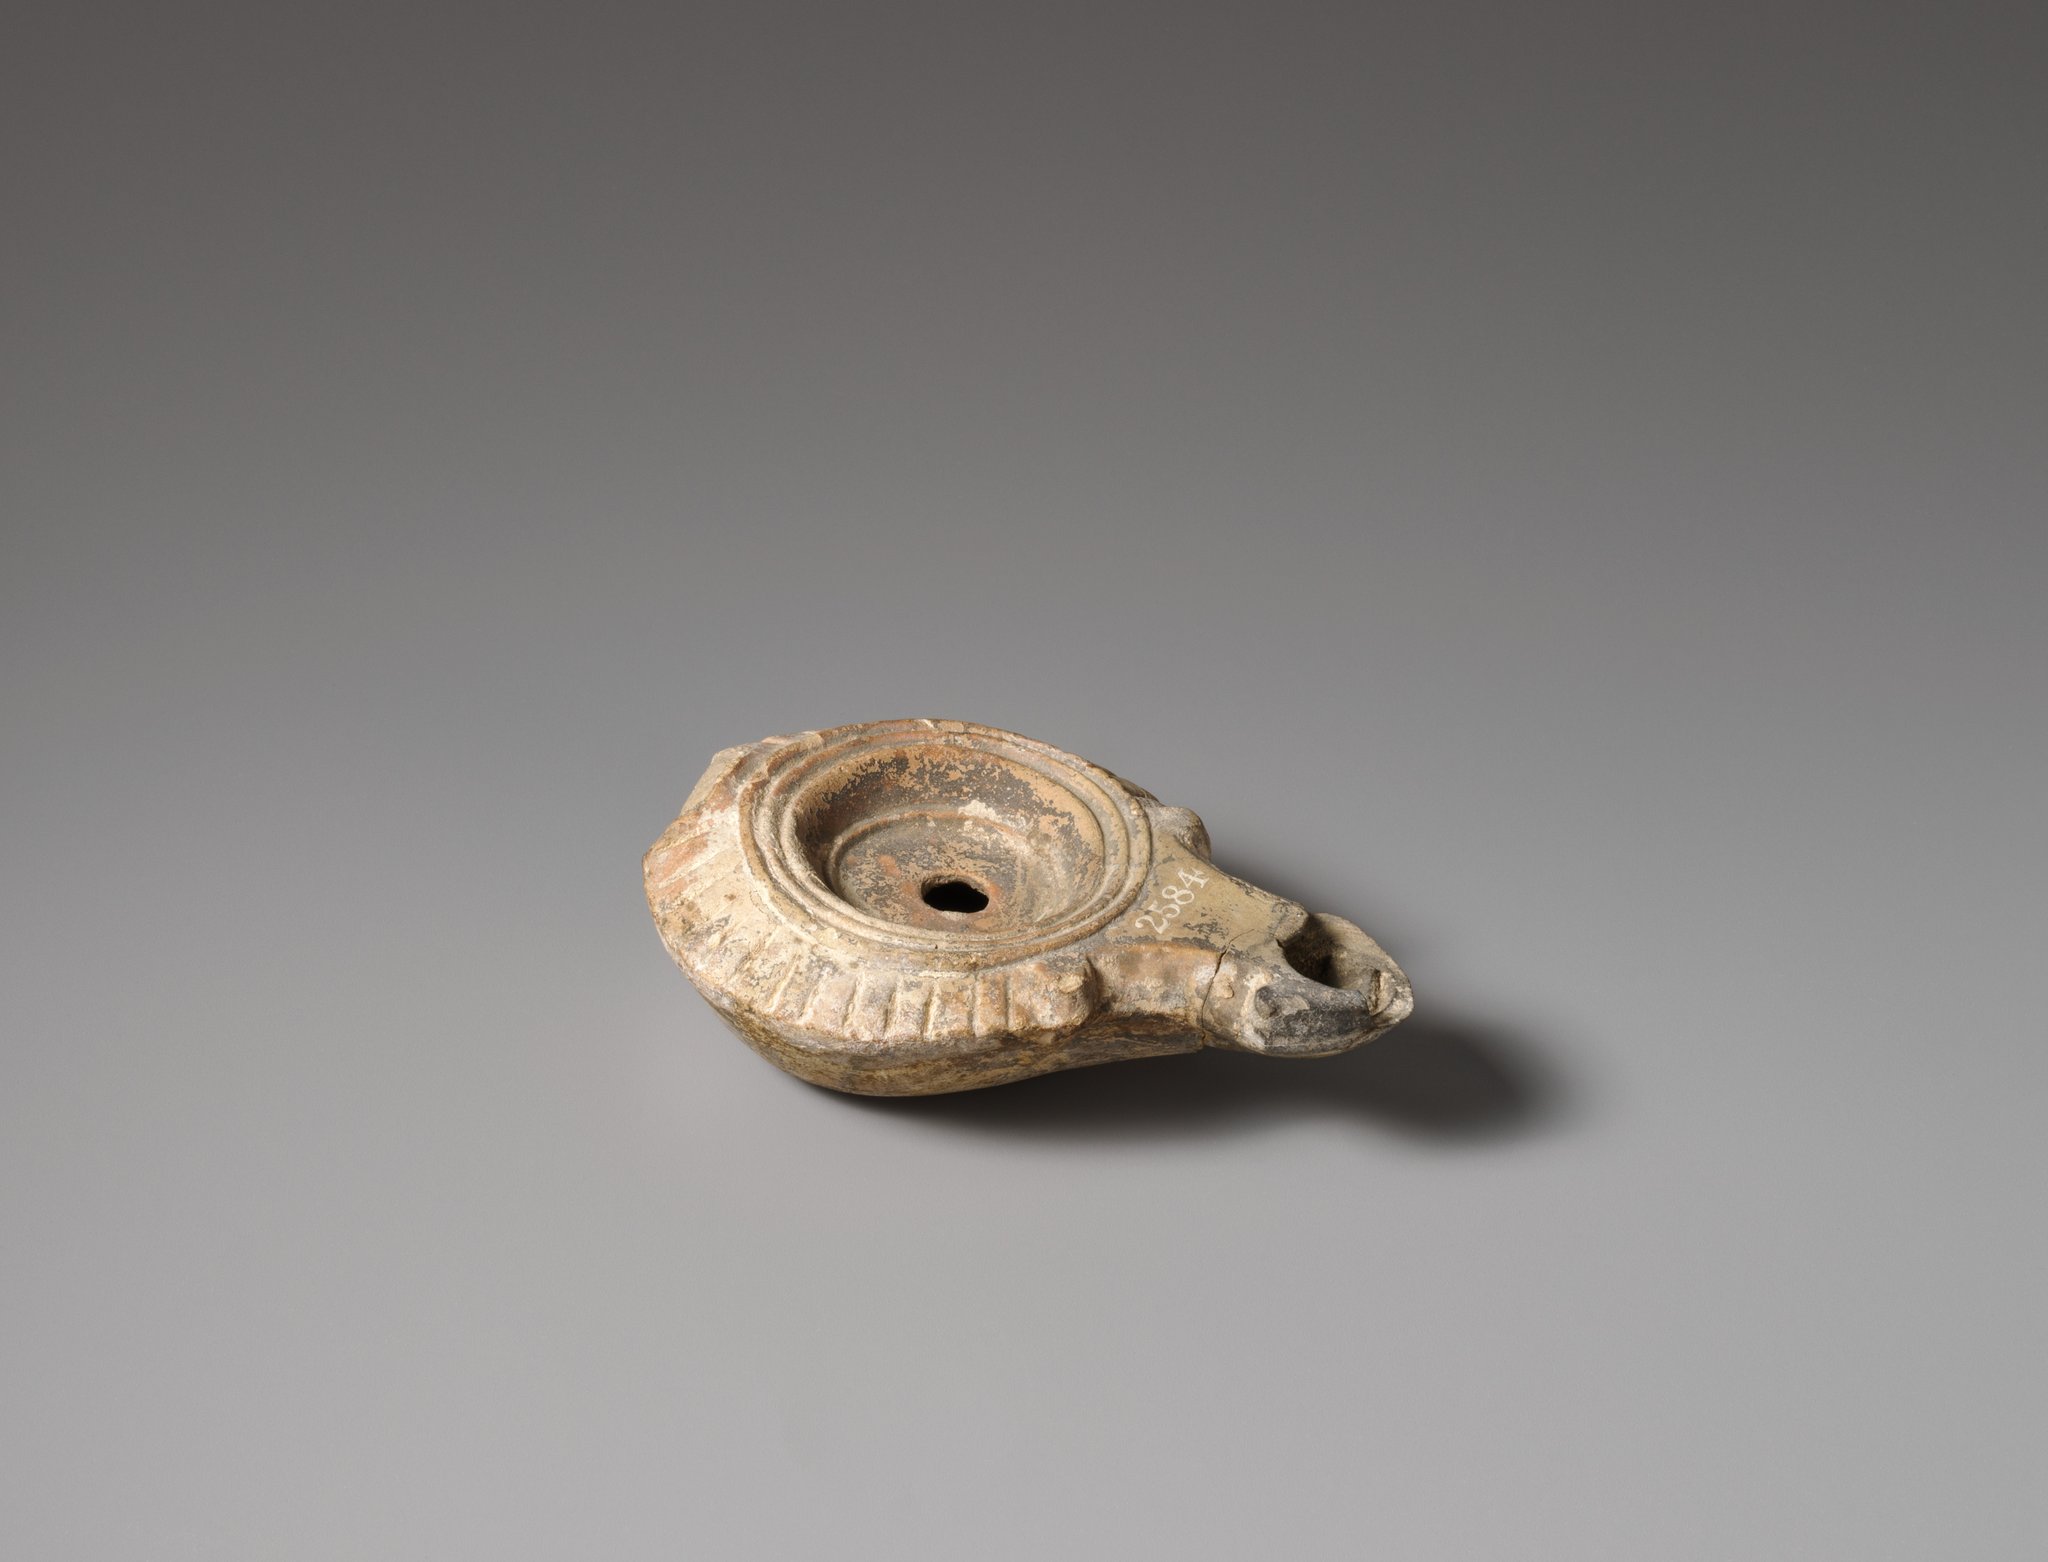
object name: lamp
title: Terracotta oil lamp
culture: roman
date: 100 BCE-100 CE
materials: terracotta